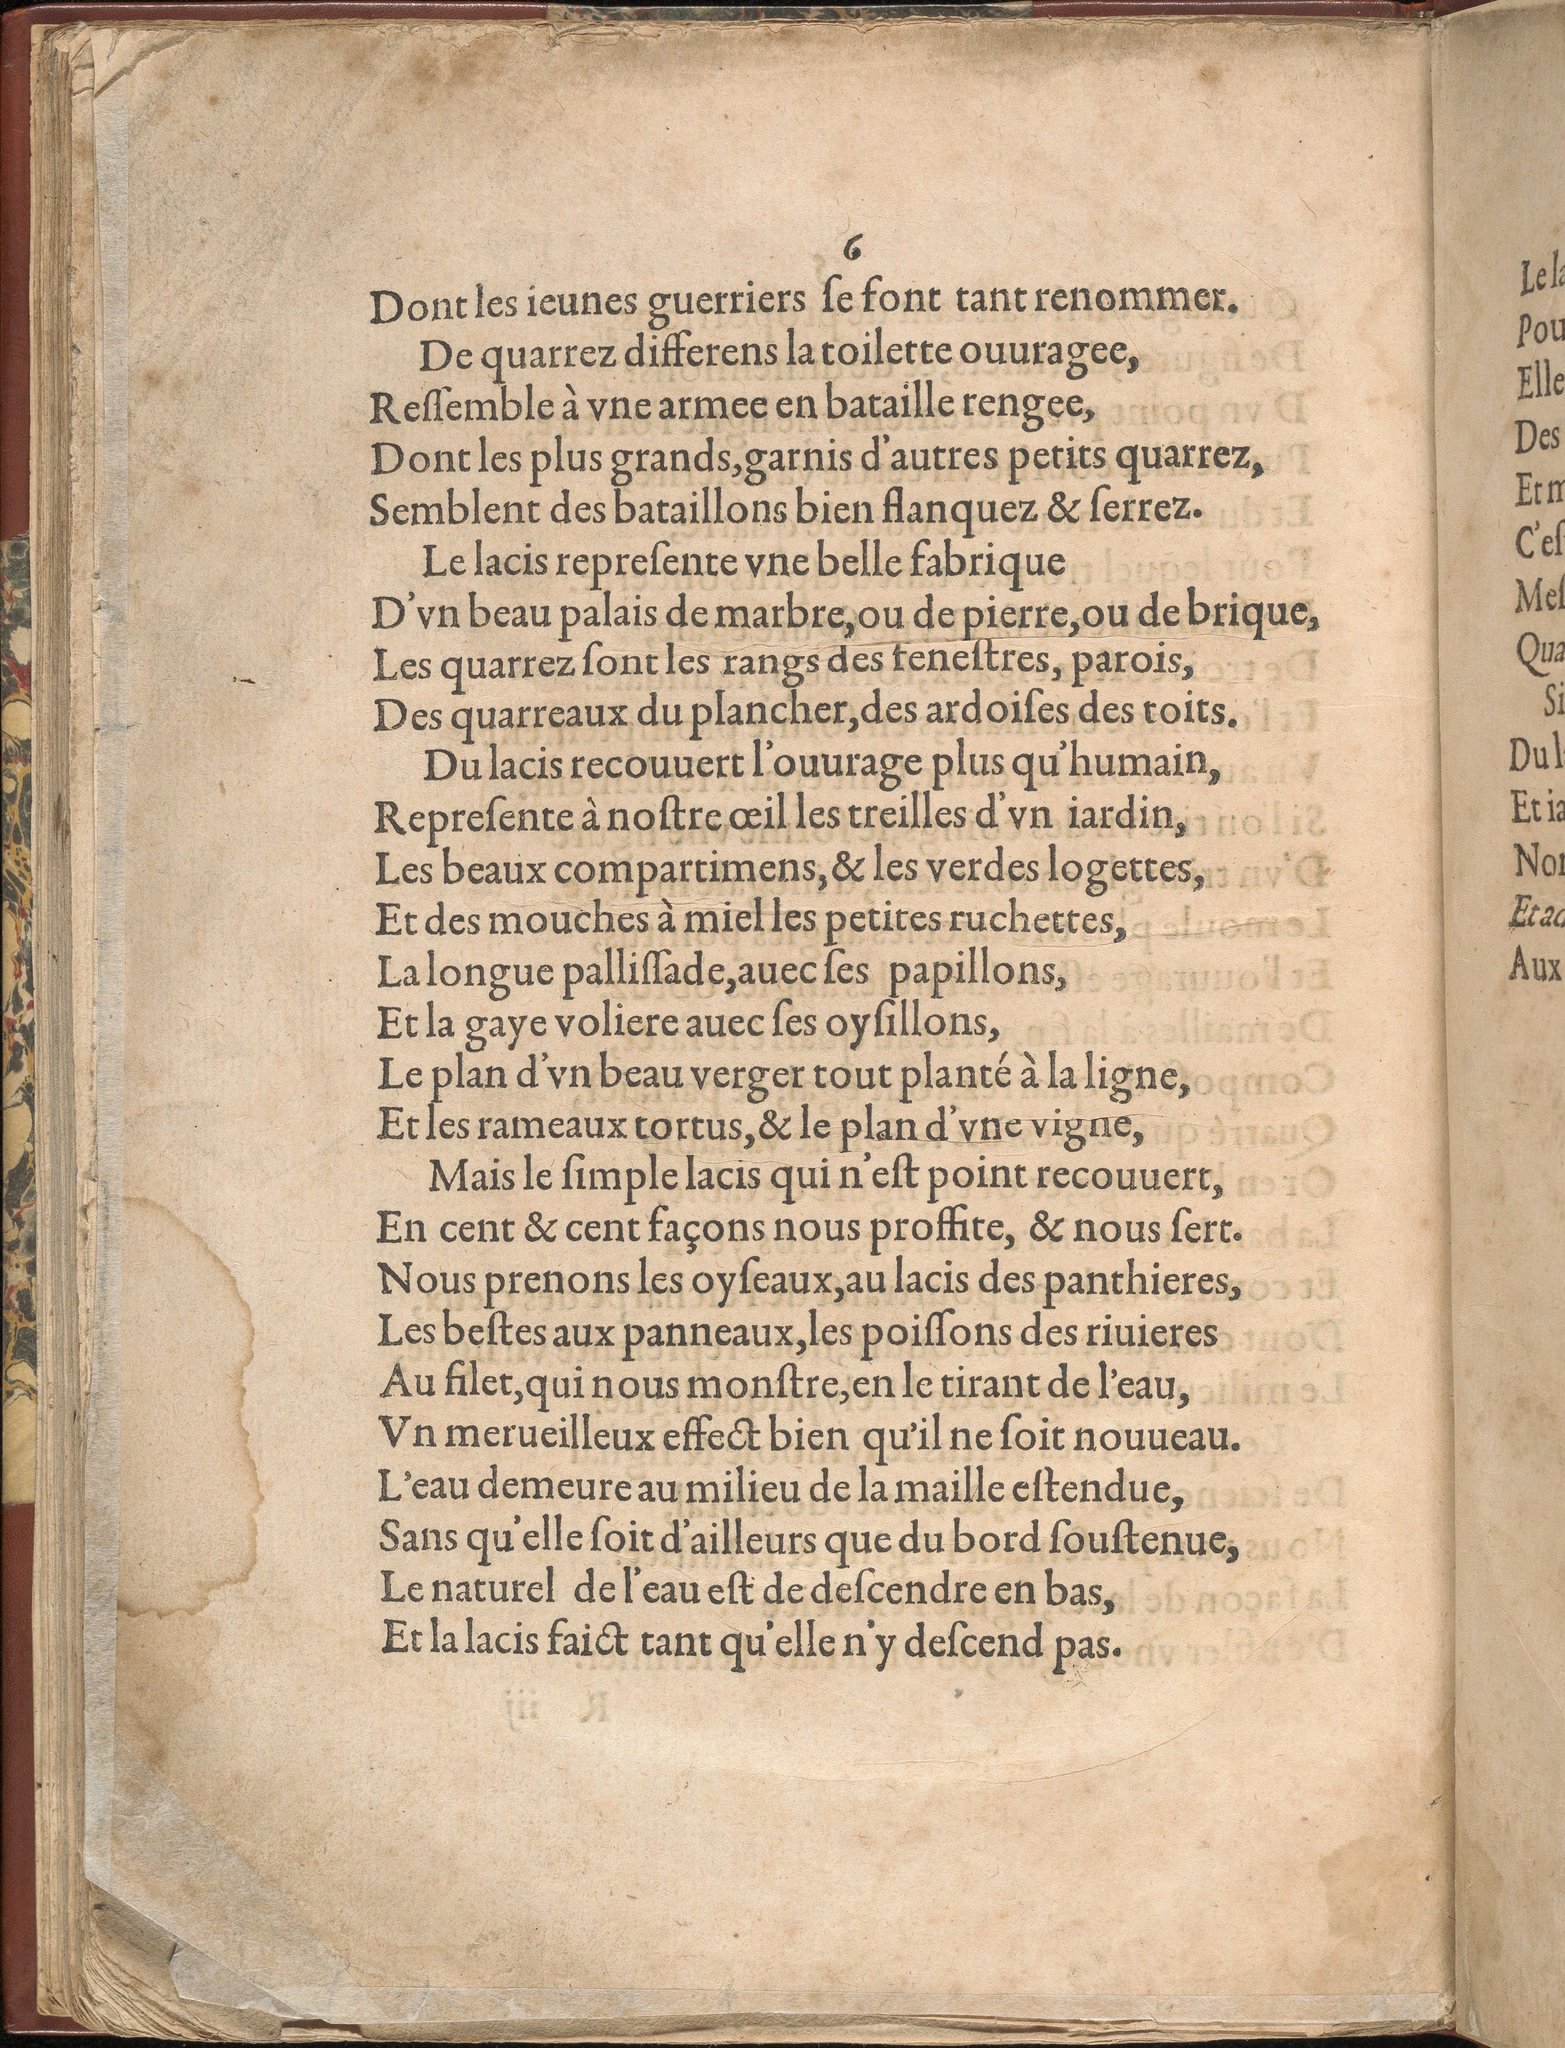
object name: book print ornament architecture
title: Les Secondes Oeuvres, et Subtiles Inventions De Lingerie du Seigneur Federic de Vinciolo Venitien, page 67 (verso)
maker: federico de vinciolo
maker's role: designer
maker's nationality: italian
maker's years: 1582-1599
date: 1603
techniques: woodcut